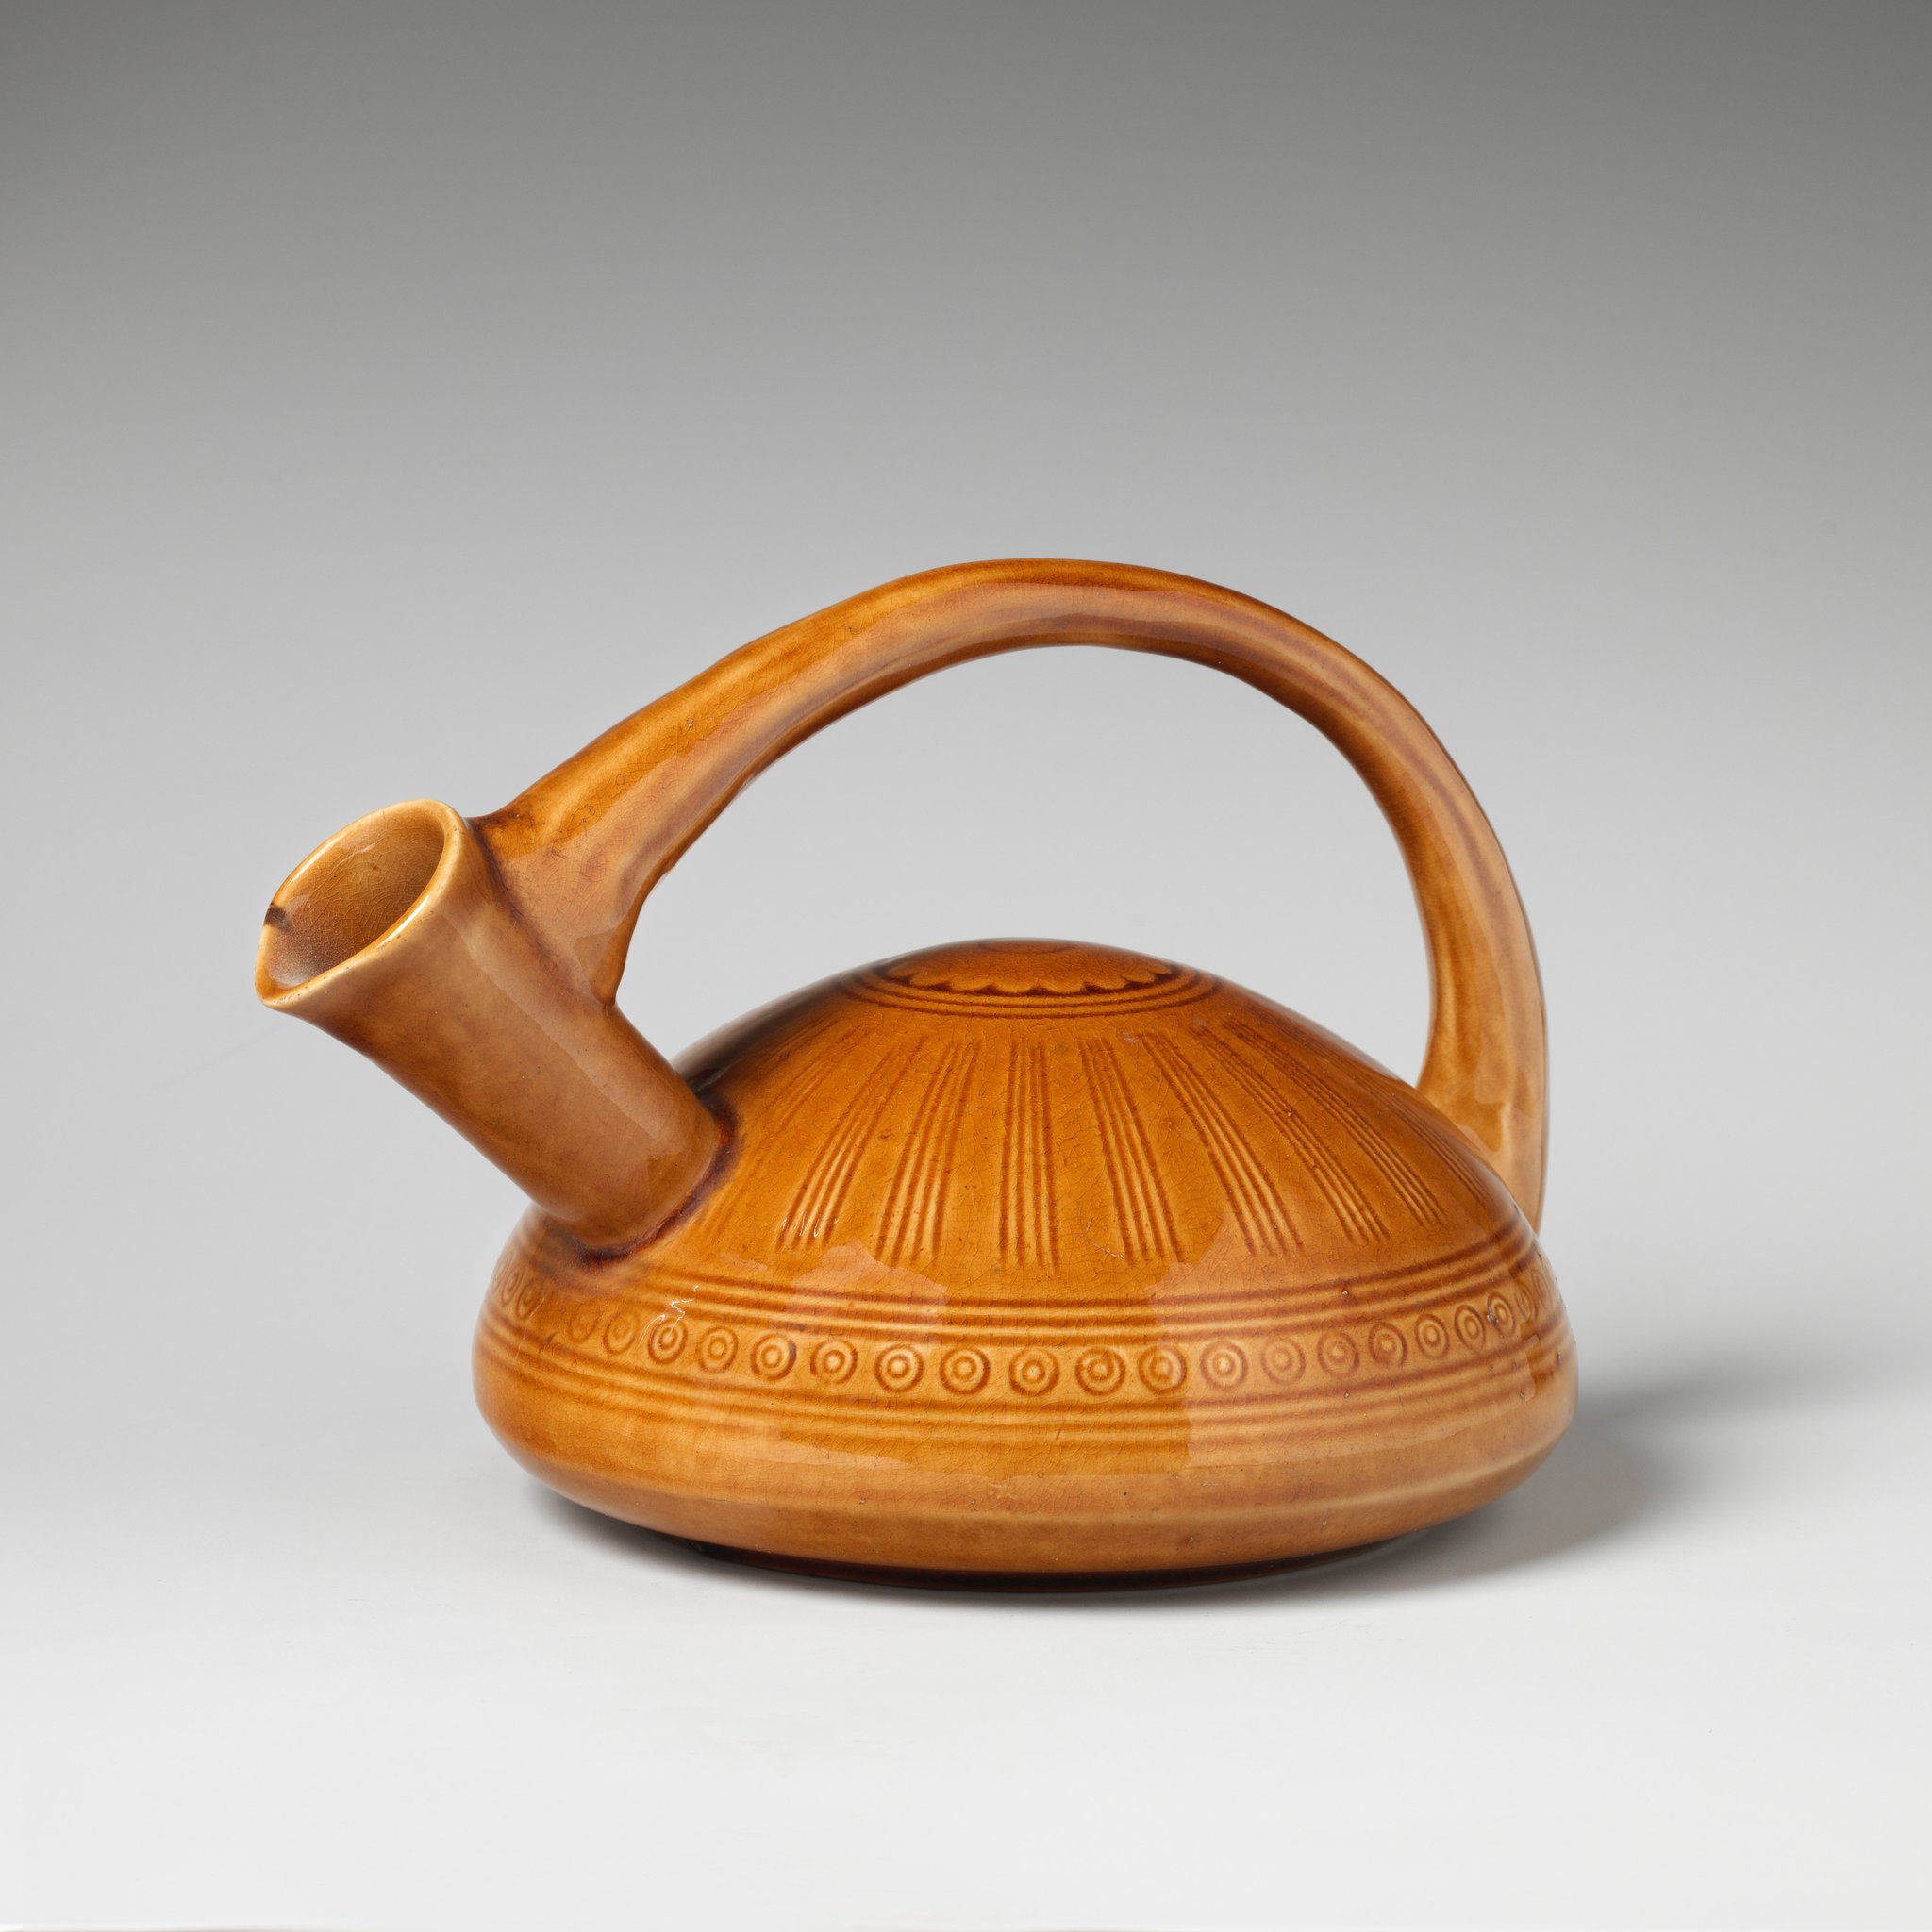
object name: pitcher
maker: christopher dresser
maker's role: designer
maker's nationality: british, scottish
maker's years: 1834-1904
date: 1880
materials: earthenware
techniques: glazing